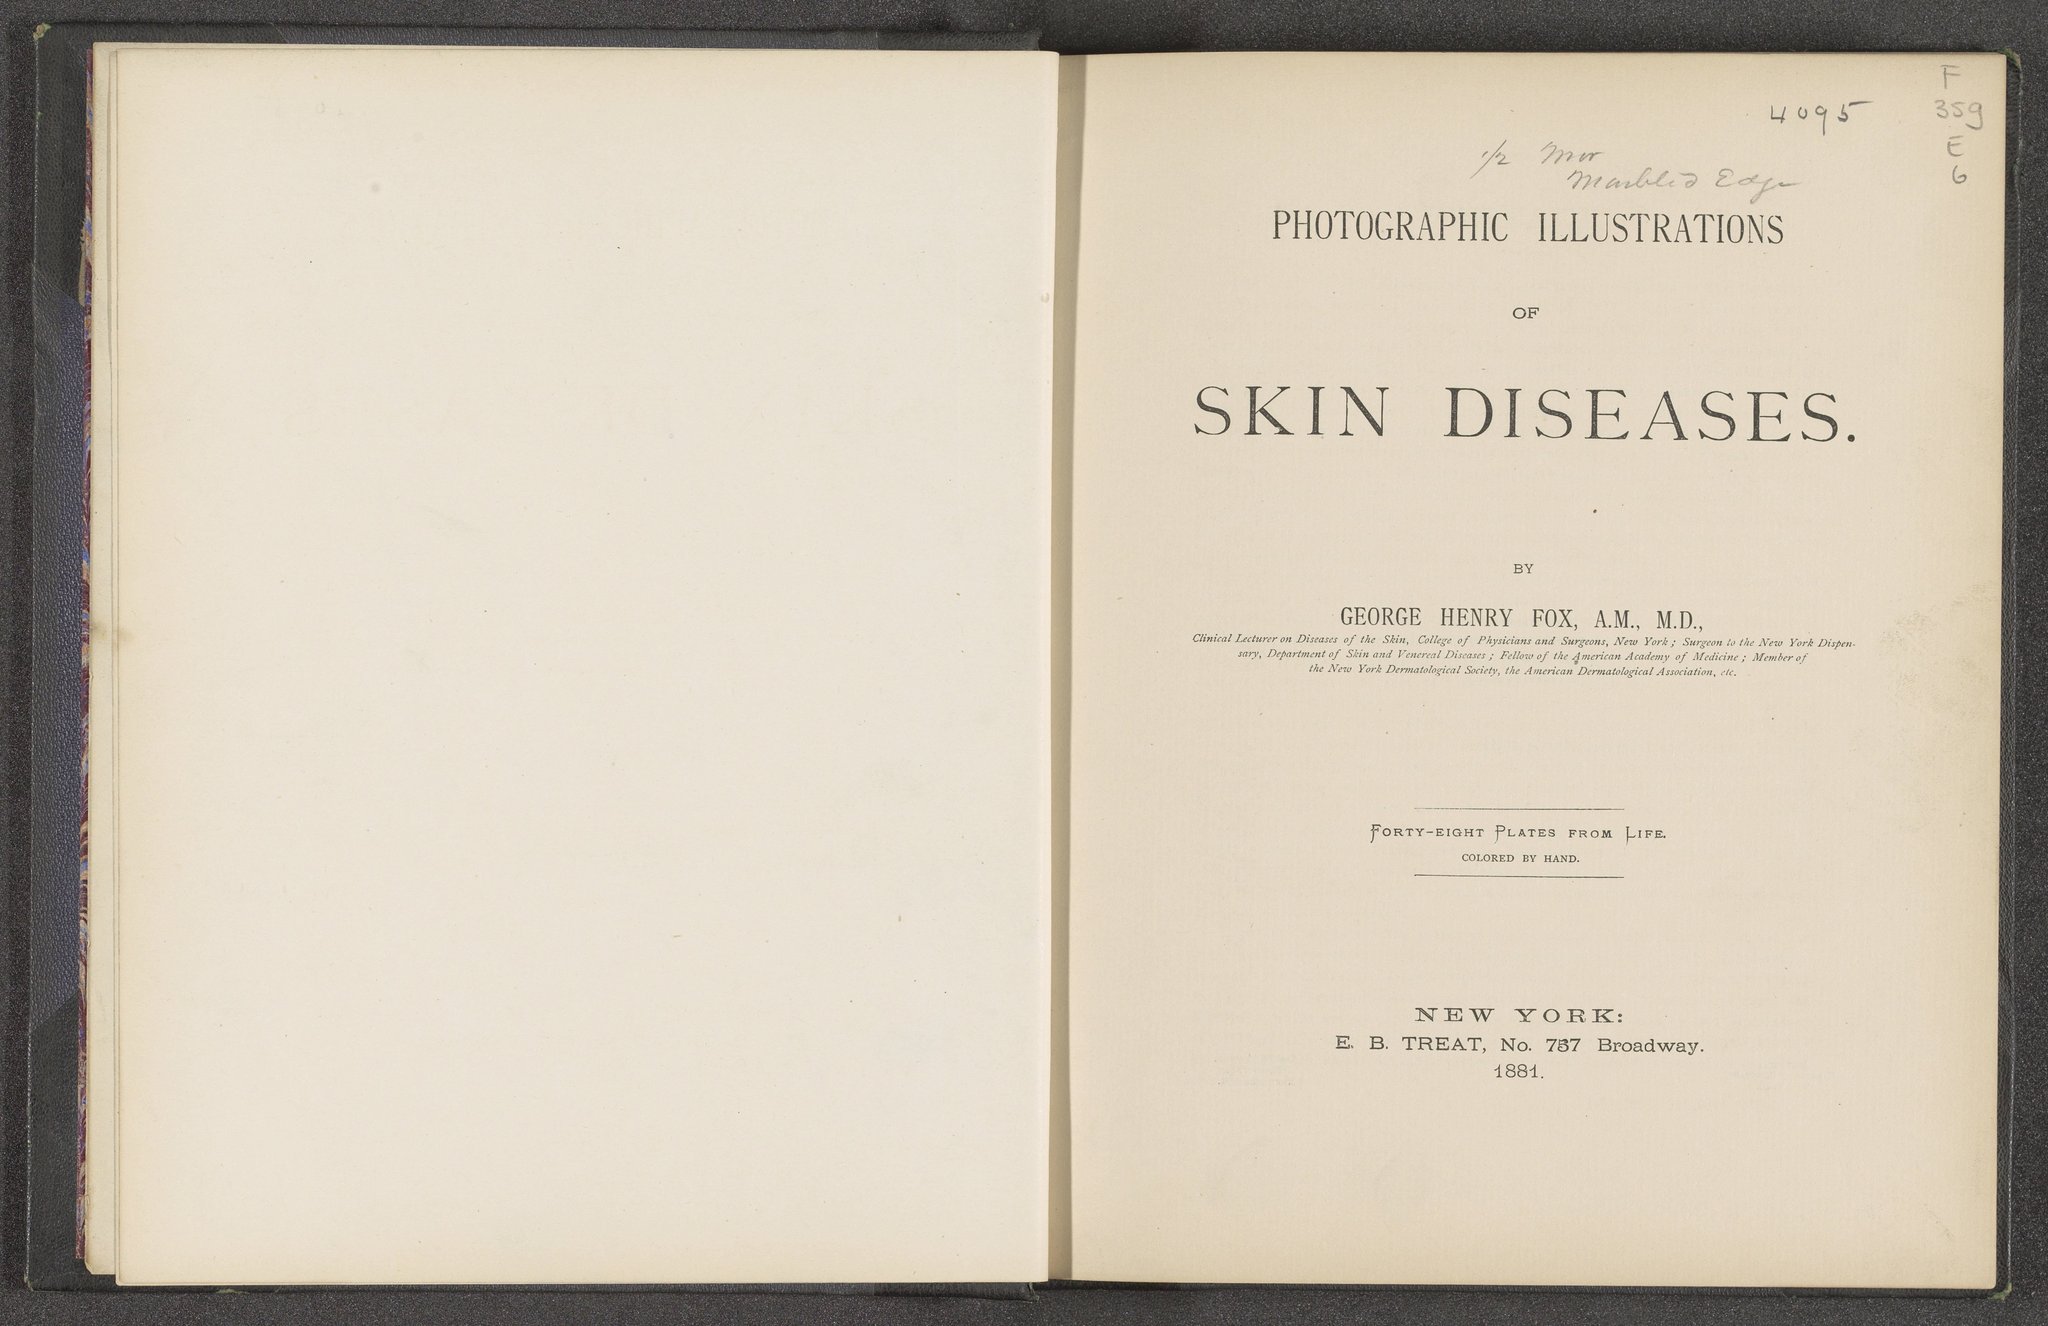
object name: book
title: Photographic illustrations of skin diseases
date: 1881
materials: cardboard, leather, linen, paper, photographic support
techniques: photograph, marbled paper, hand coloring, lithograph, printing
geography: new york city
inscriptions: name: ‘Leonard Freeman’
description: In het boek zijn de pagina's 39 tm 46 dubbel opgenomen, evenals de bijbehorende prenten.